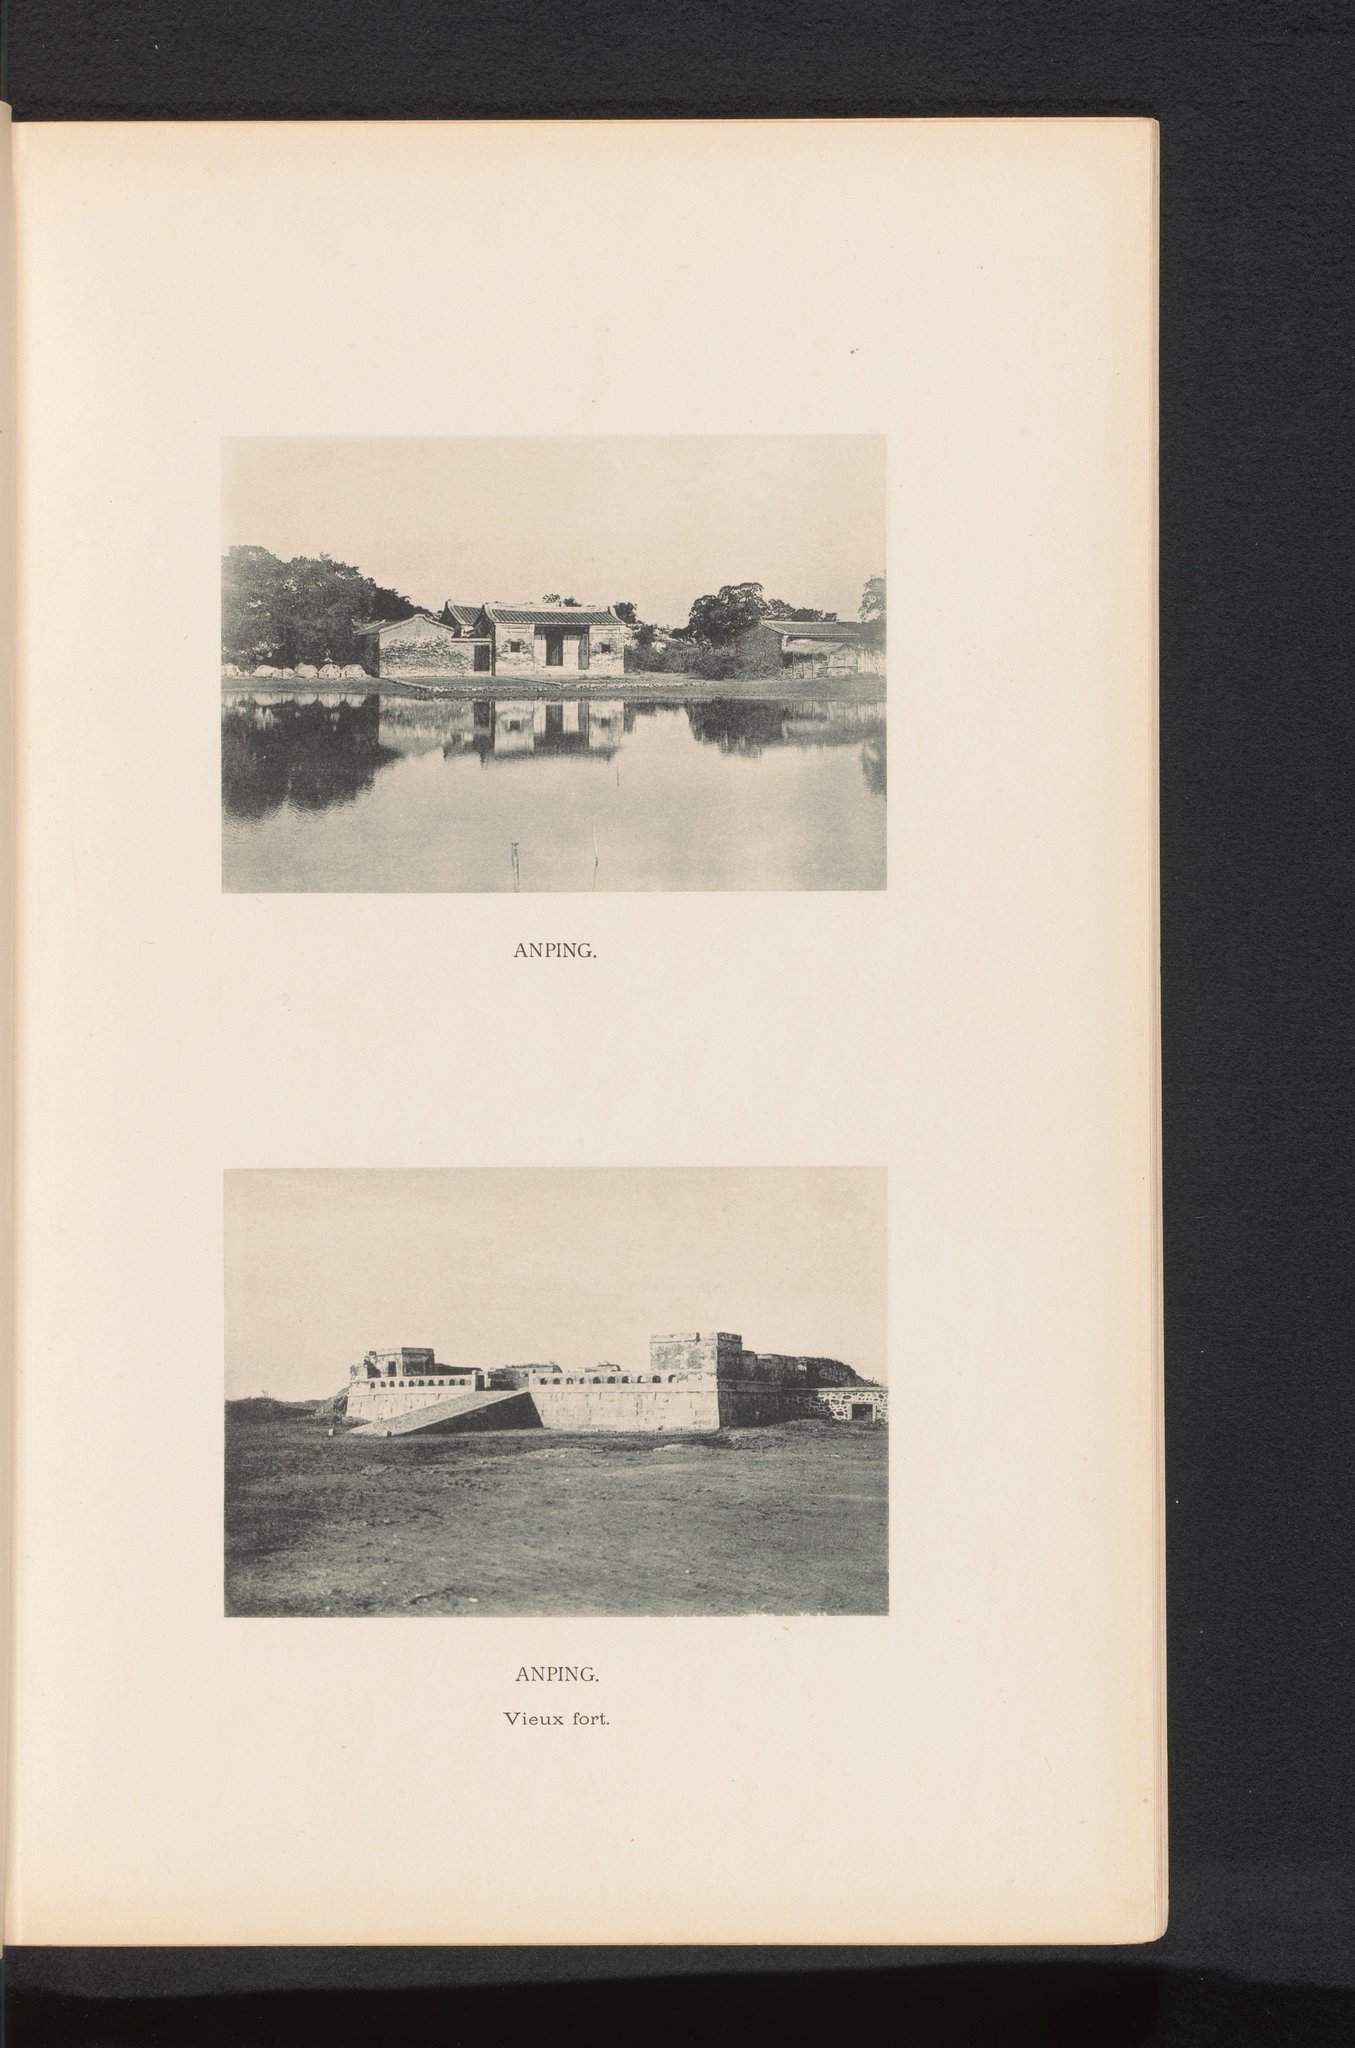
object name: page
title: Anping. Vieux fort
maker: Anonymous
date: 1891-1896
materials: paper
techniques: photograph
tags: fortress, farm or solitary house in landscape